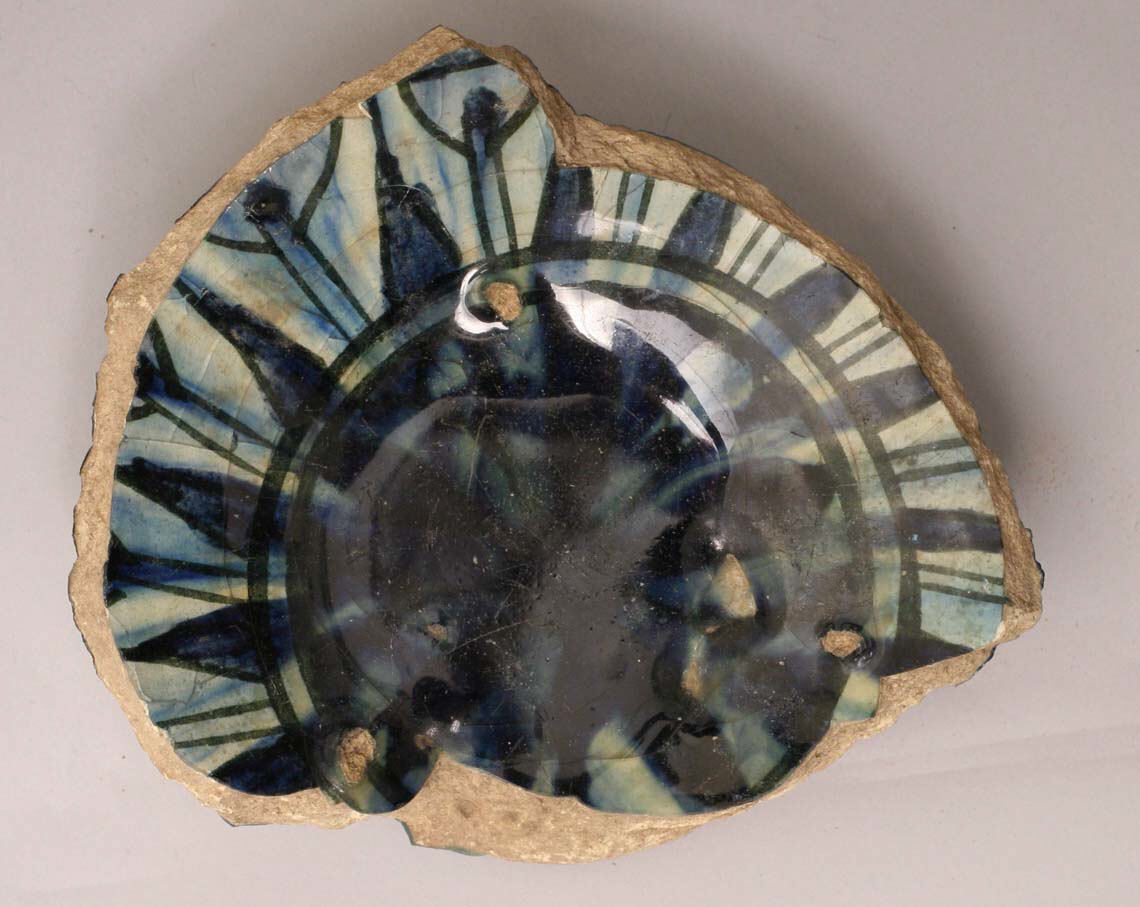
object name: fragment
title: Fragment of a Bowl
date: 1301-1500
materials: stonepaste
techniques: painting, underglaze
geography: egypt